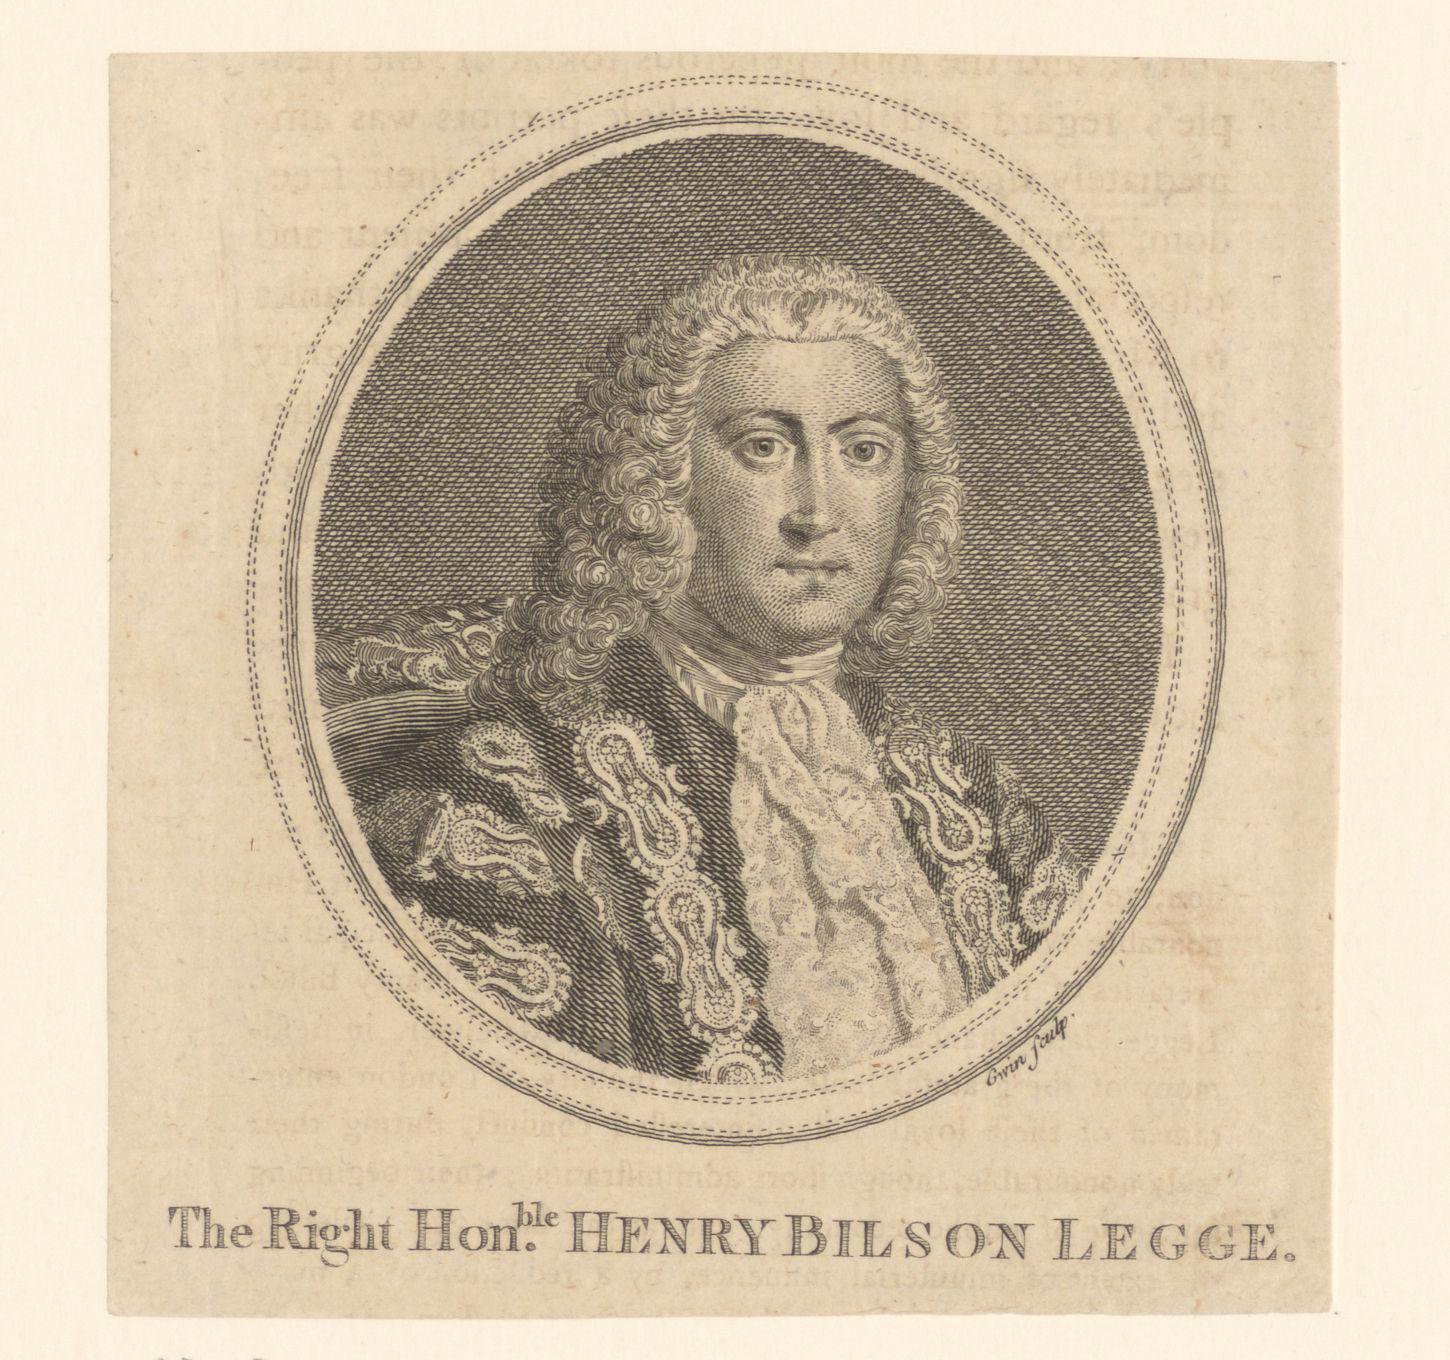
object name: print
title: Portret van Henry Bilson-Legge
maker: john gwynn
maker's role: print maker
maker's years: 1713-1786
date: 1754-1786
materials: paper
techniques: engraving, etching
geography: england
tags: politician, historical persons, politician, e.g. party leader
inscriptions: collector's mark: Lugt 2228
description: Prent komt uit een niet geïdentificeerde publicatie.